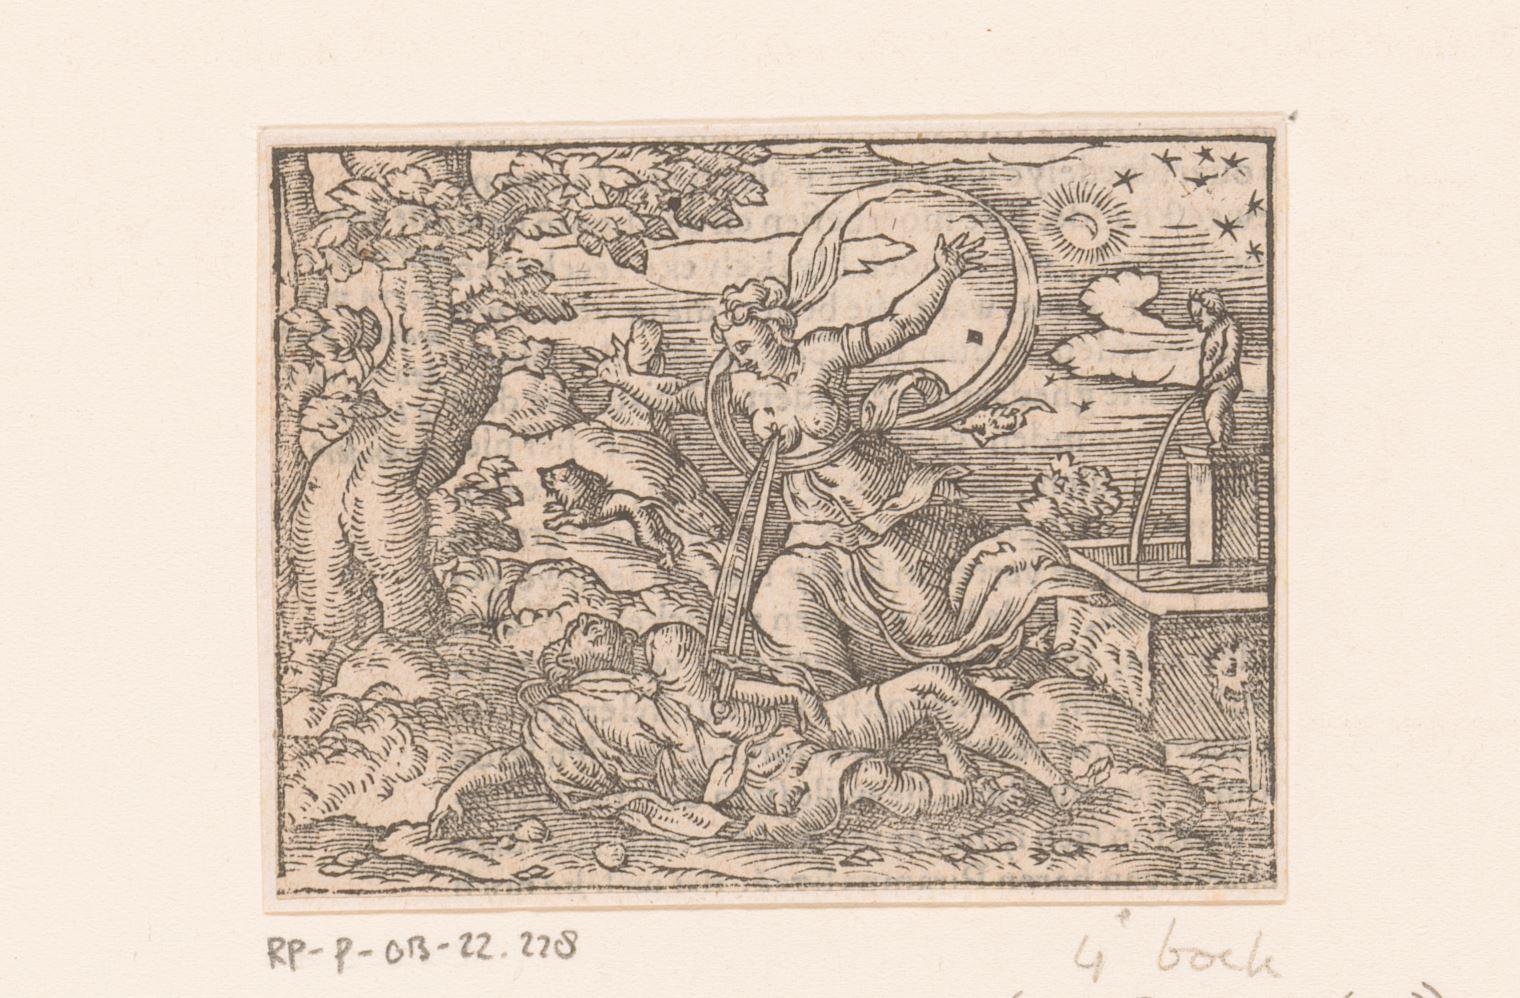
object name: book illustration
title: Thisbe doodt zichzelf met het zwaard van Pyramus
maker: Anonymous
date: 1524-1612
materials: paper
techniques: woodcut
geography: nuremberg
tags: thisbe kills herself with pyramus' sword (the scene may be represented near a fountain)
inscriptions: collector's mark: Lugt 240